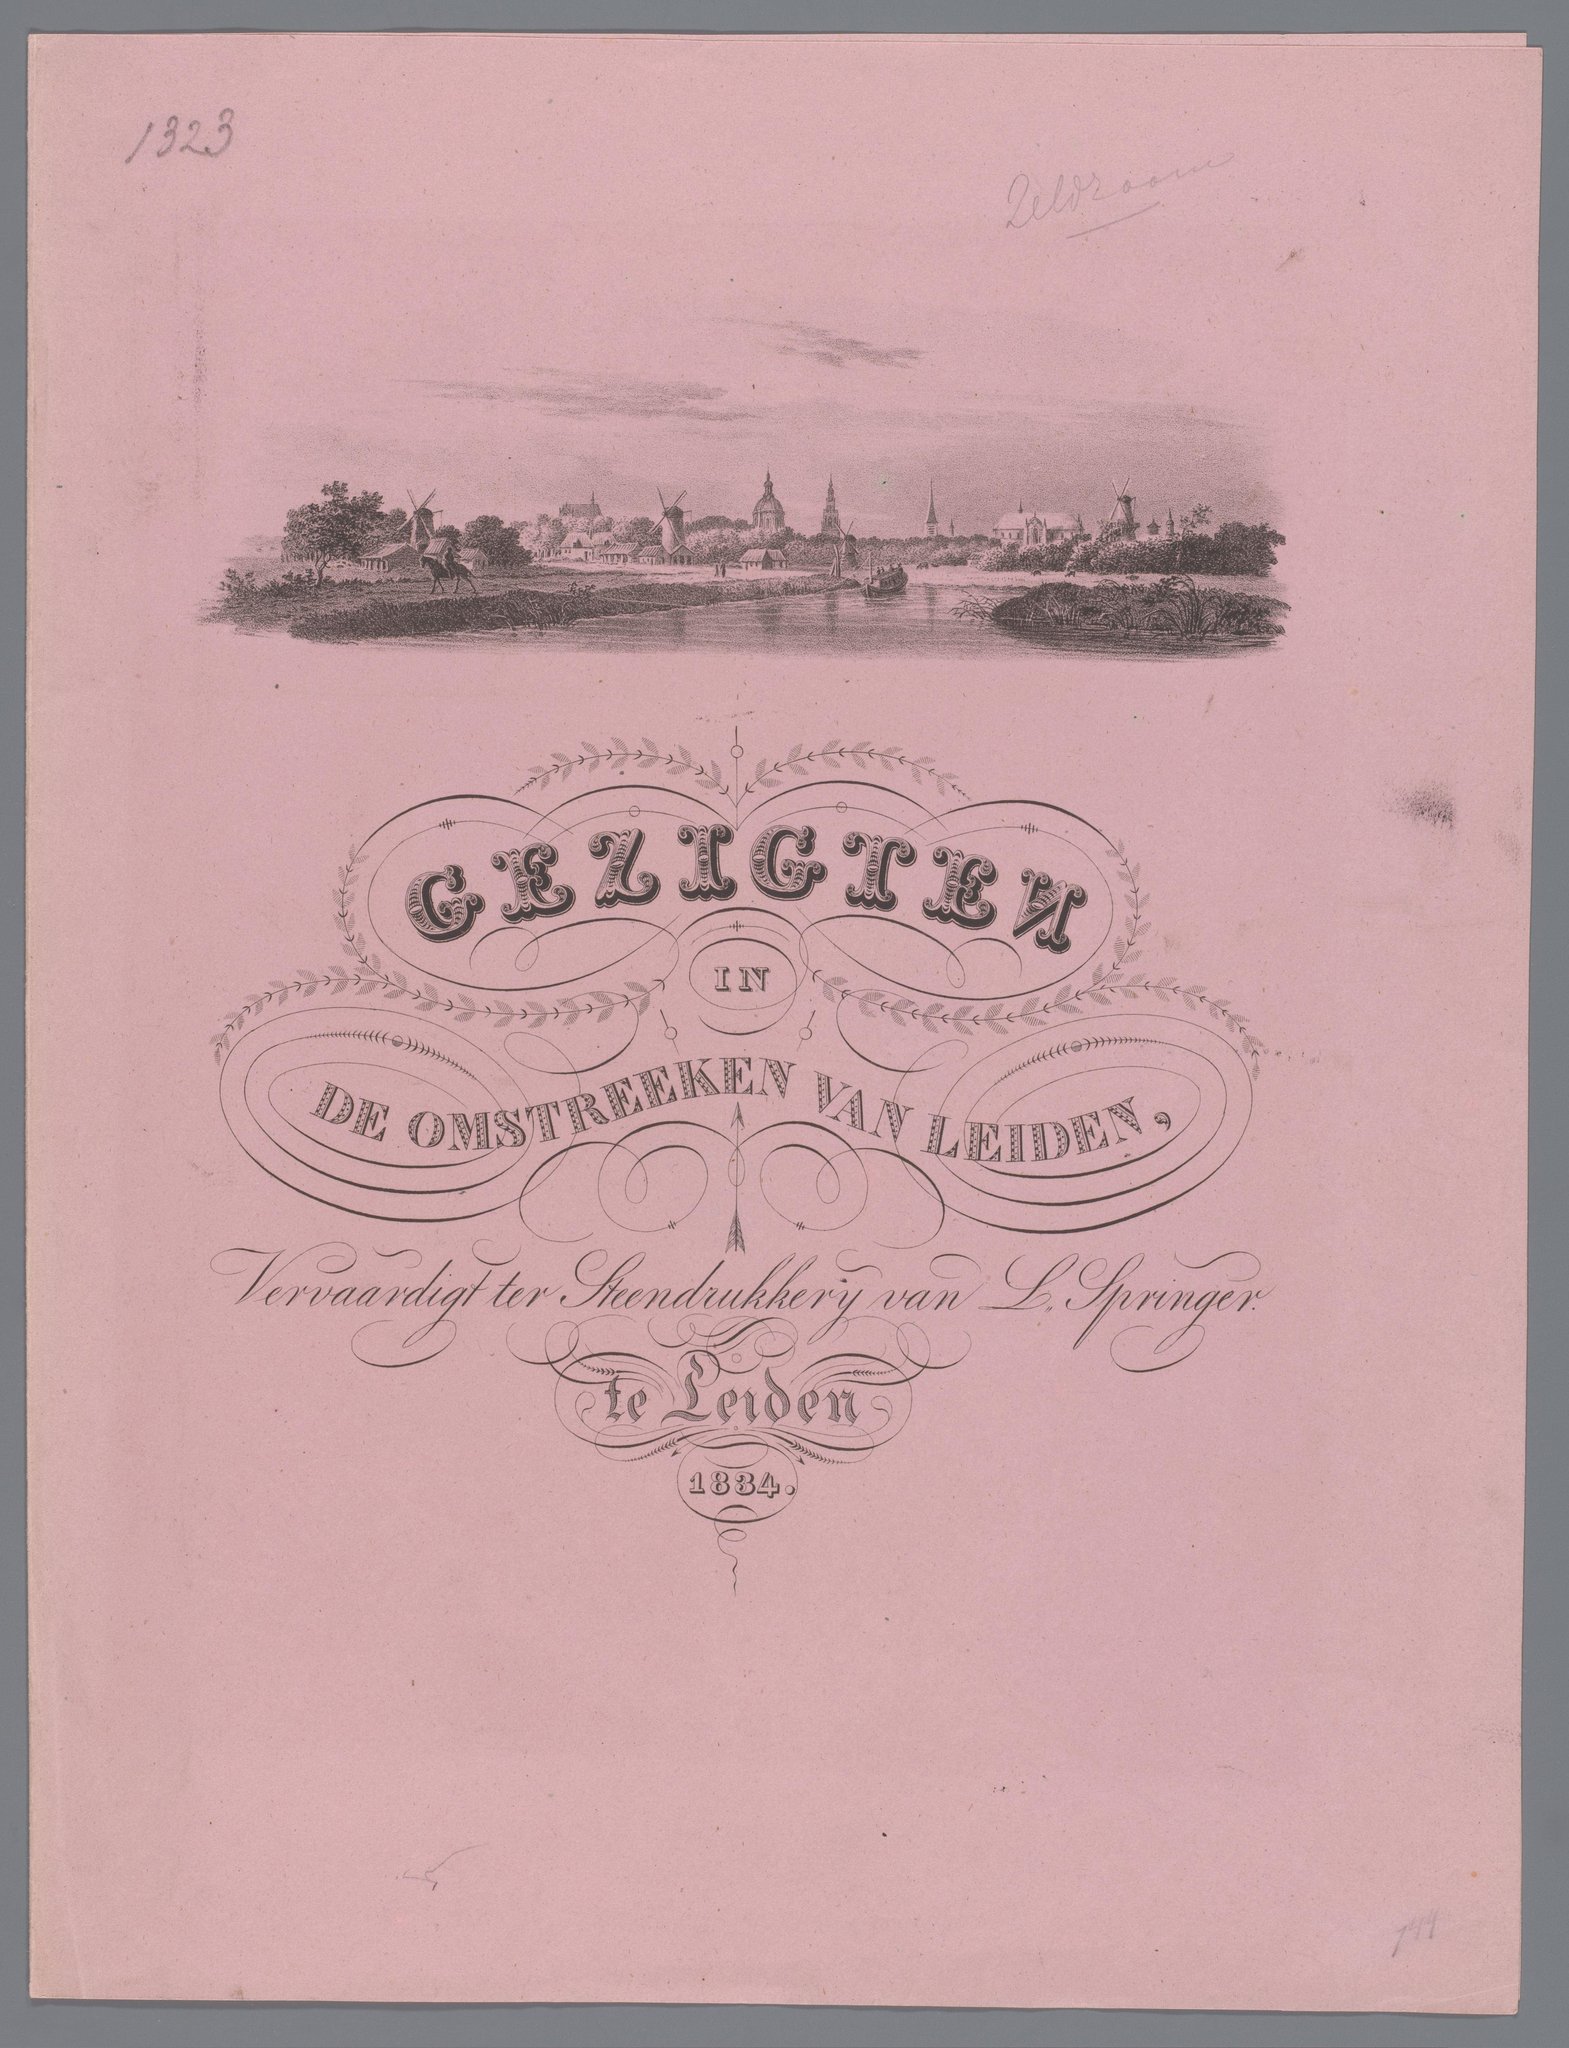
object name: wrapper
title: Omslag voor: Gezigten in de omstreeken van Leiden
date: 1834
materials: paper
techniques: lithograph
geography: leiden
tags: traffic on the water (+ propulsion of vehicle, ship, etc. by animals), tow-boat, towing-barge, river (+ landscape with figures, staffage), leiden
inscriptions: collector's mark: Lugt 2228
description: Bovenin een rivierlandschap met een trekschuit. Omslag met acht prenten.